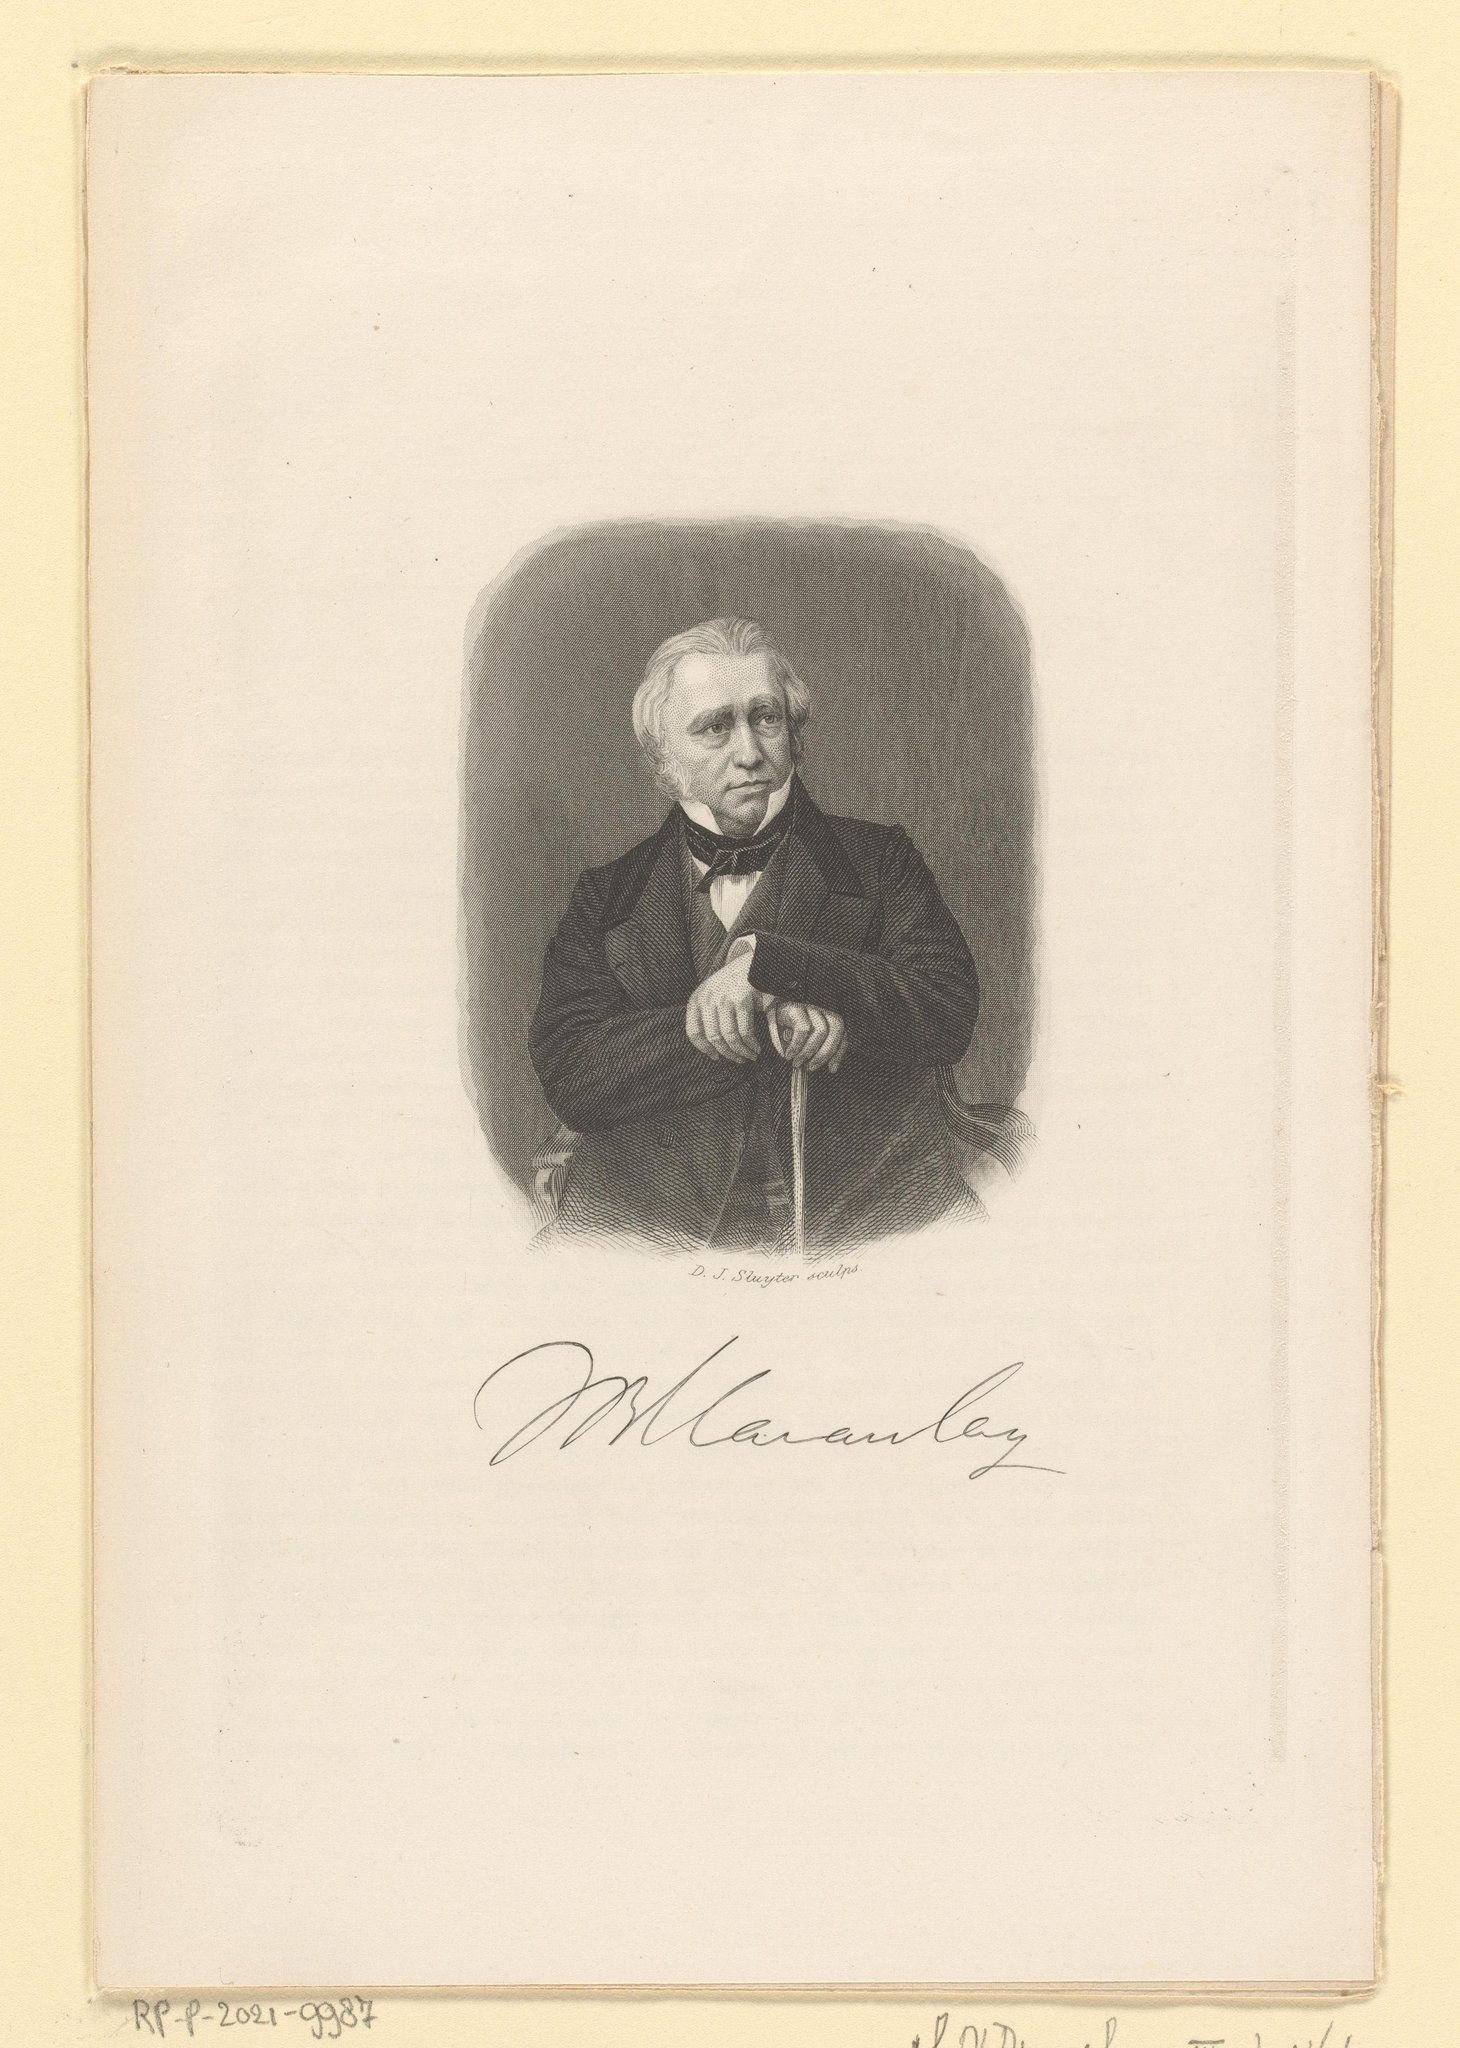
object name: print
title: Portret van Thomas Babington Macaulay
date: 1869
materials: paper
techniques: engraving, letterpress printing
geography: amsterdam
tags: london, thomas babington macaulay, historical persons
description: Prent uit: Macaulay, Thomas Babington. Geschiedenis van Engeland sedert de troonbestijging van Jacobus II (...). Amsterdam: weduwe Johannes Christoffel van Kesteren, 1869, dl. 1.